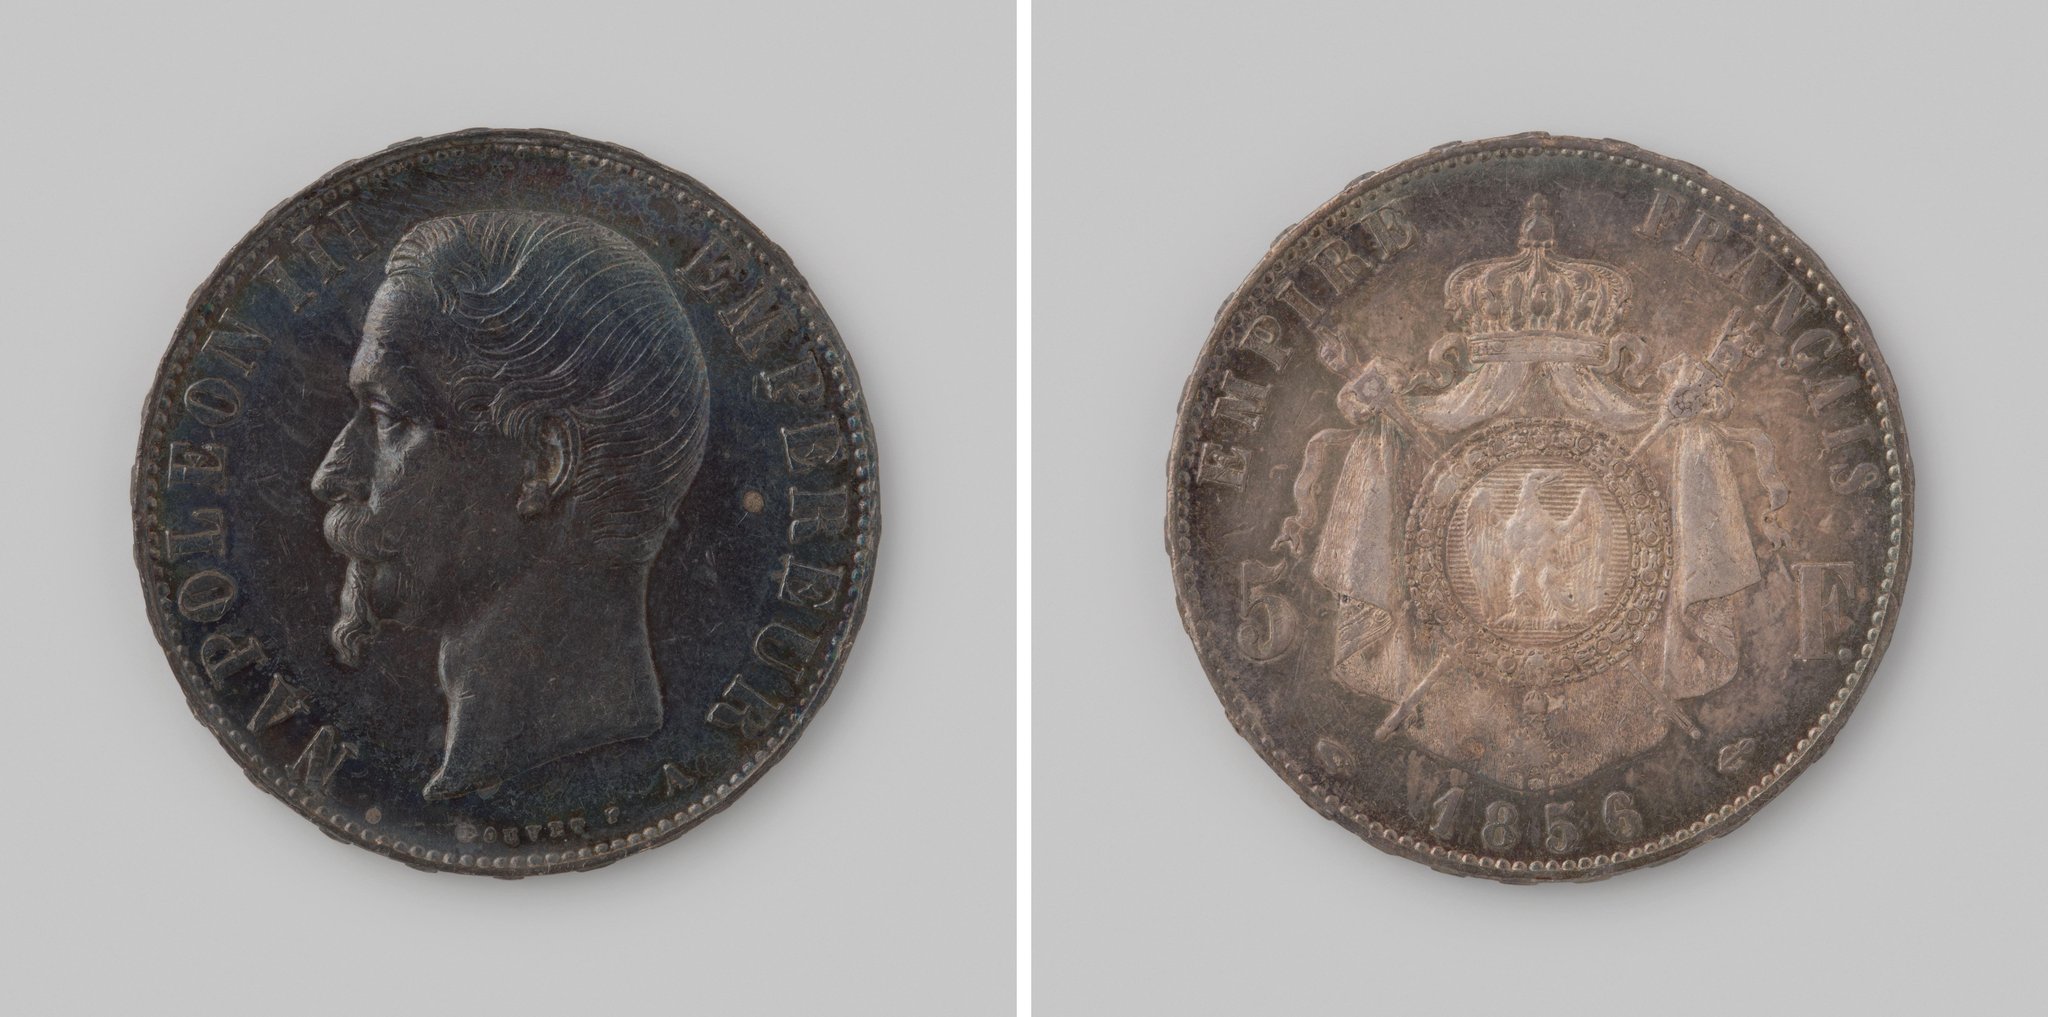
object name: coin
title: 5 francs uit het keizerrijk Frankrijk van Napoleon III, 1856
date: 1856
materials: silver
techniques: striking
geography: paris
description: Zilveren munt. Voorzijde: hoofd van de keizer naar links. Rechts onderaan de letter A [=Parijs]. Keerzijde: tussen waarde-aanduiding gekroonde mantel, waarop door keten van ridderorde met juweel omhangen rond wapenschild, waarachter twee gekruiste staven. Onderaan jaartal. Opliggend randschrift.